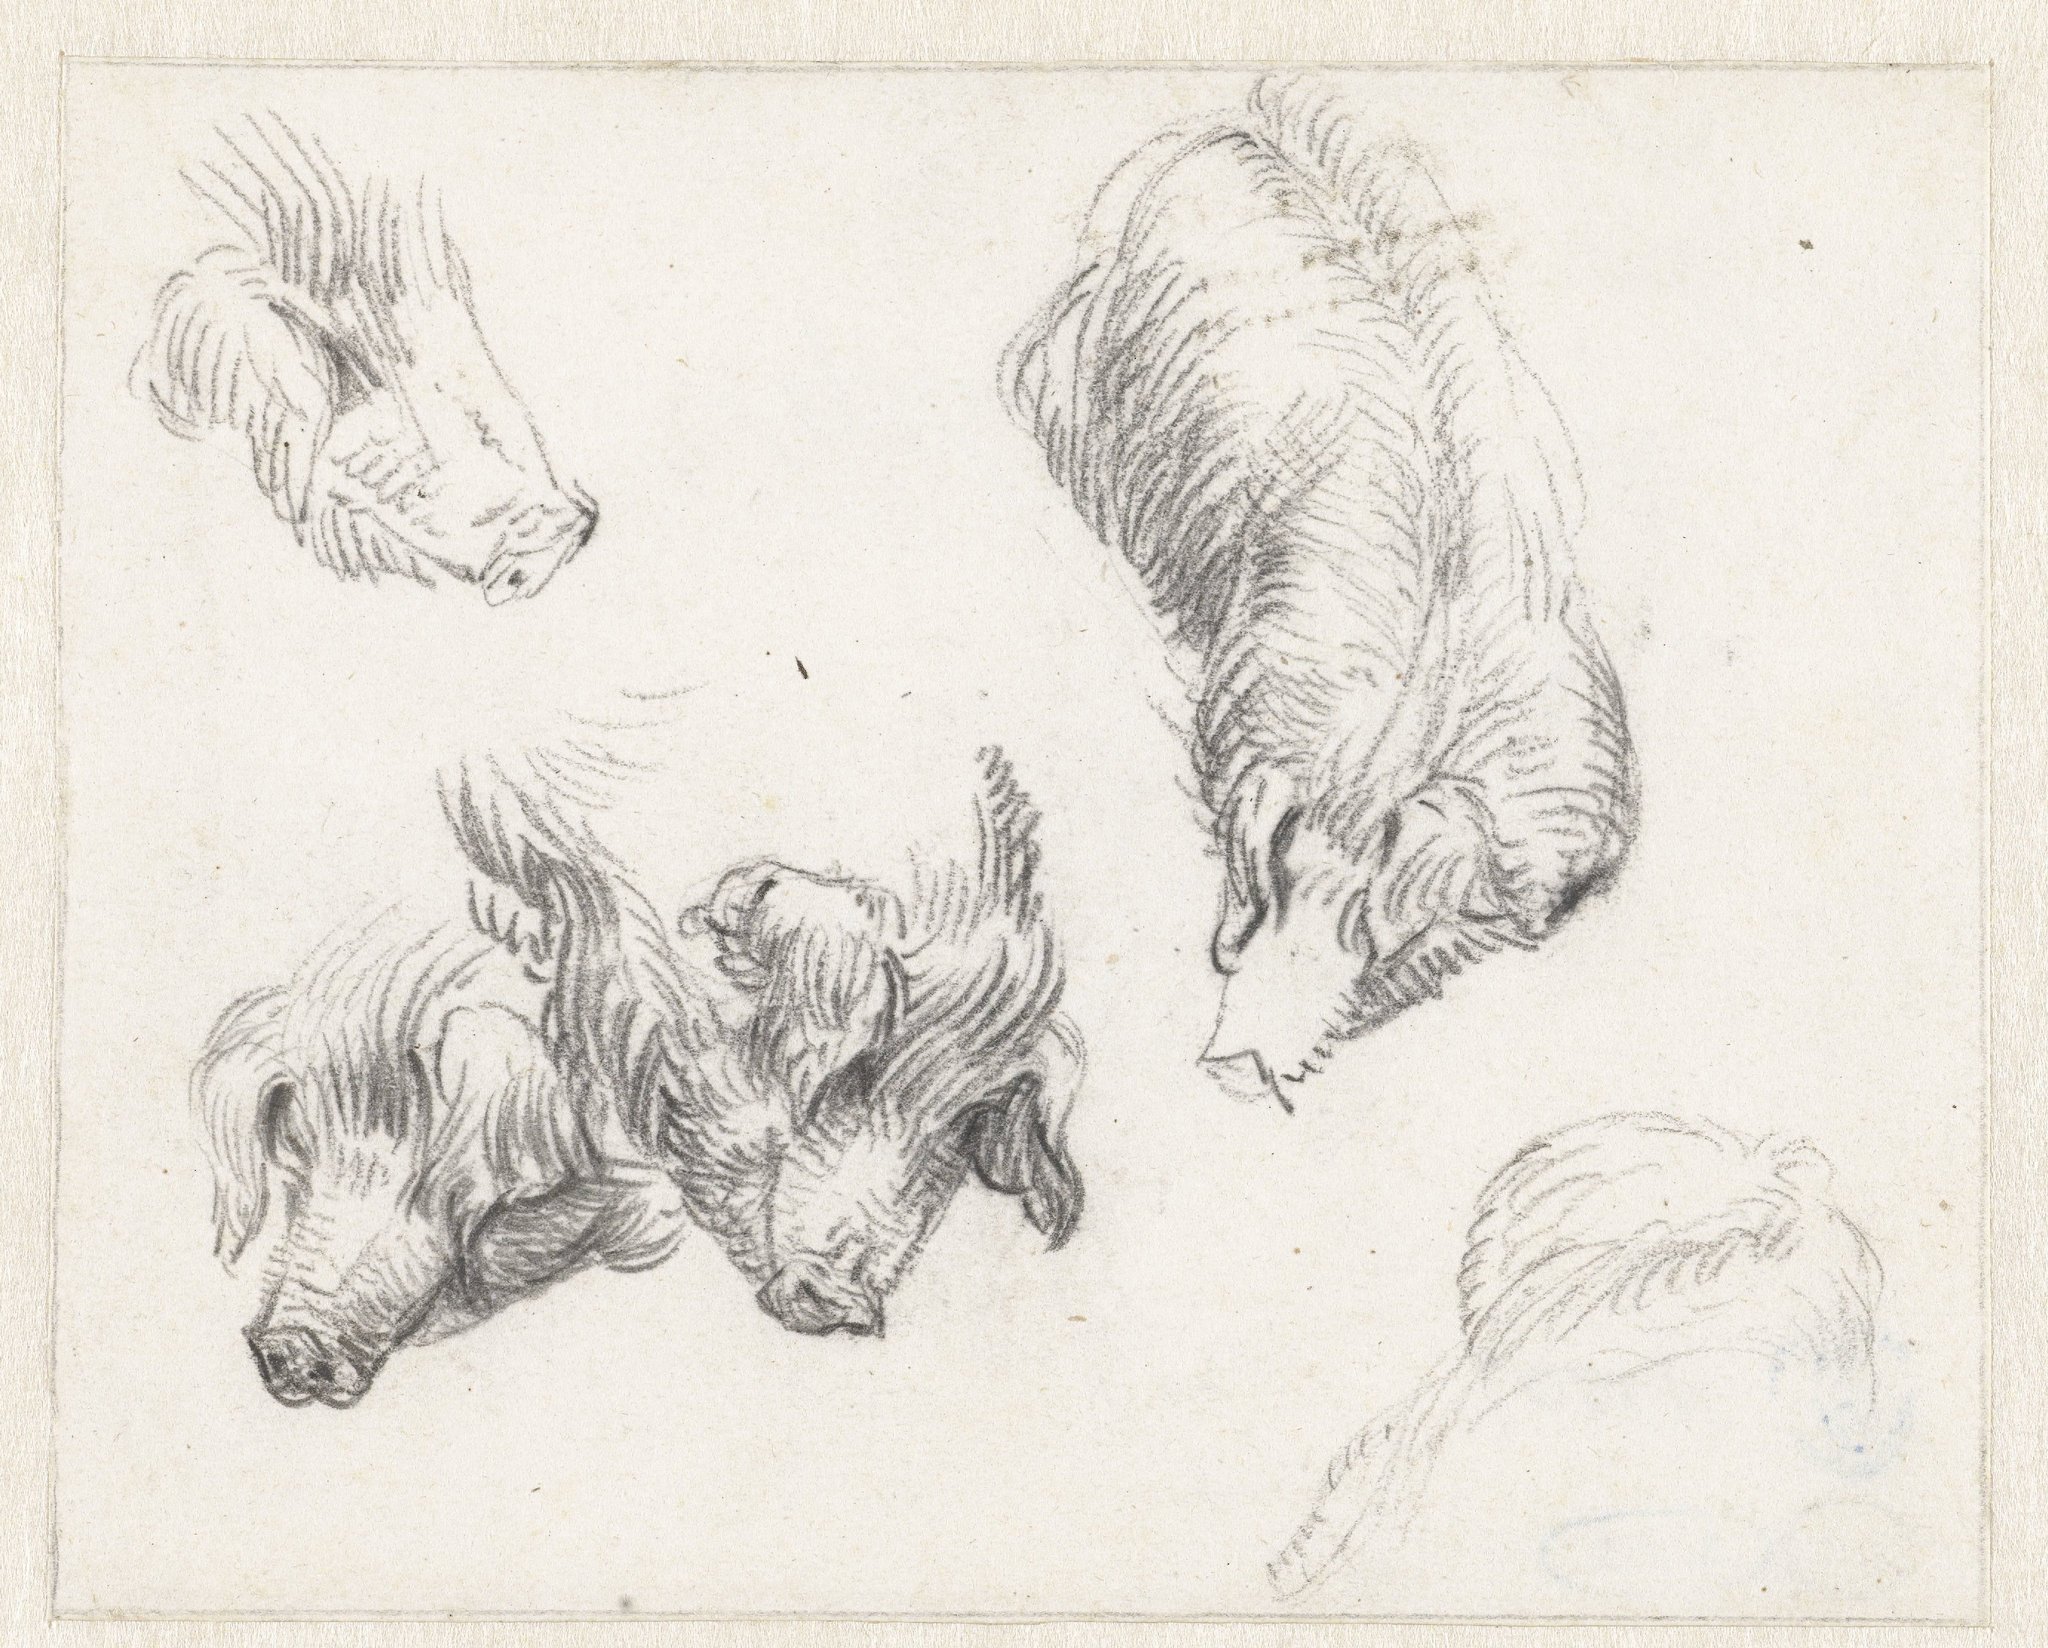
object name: drawing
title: Studieblad met zwijnskoppen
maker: simon de vlieger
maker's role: draughtsman, painter, print maker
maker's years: 1600-1653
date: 1610-1653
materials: chalk, paper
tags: pig